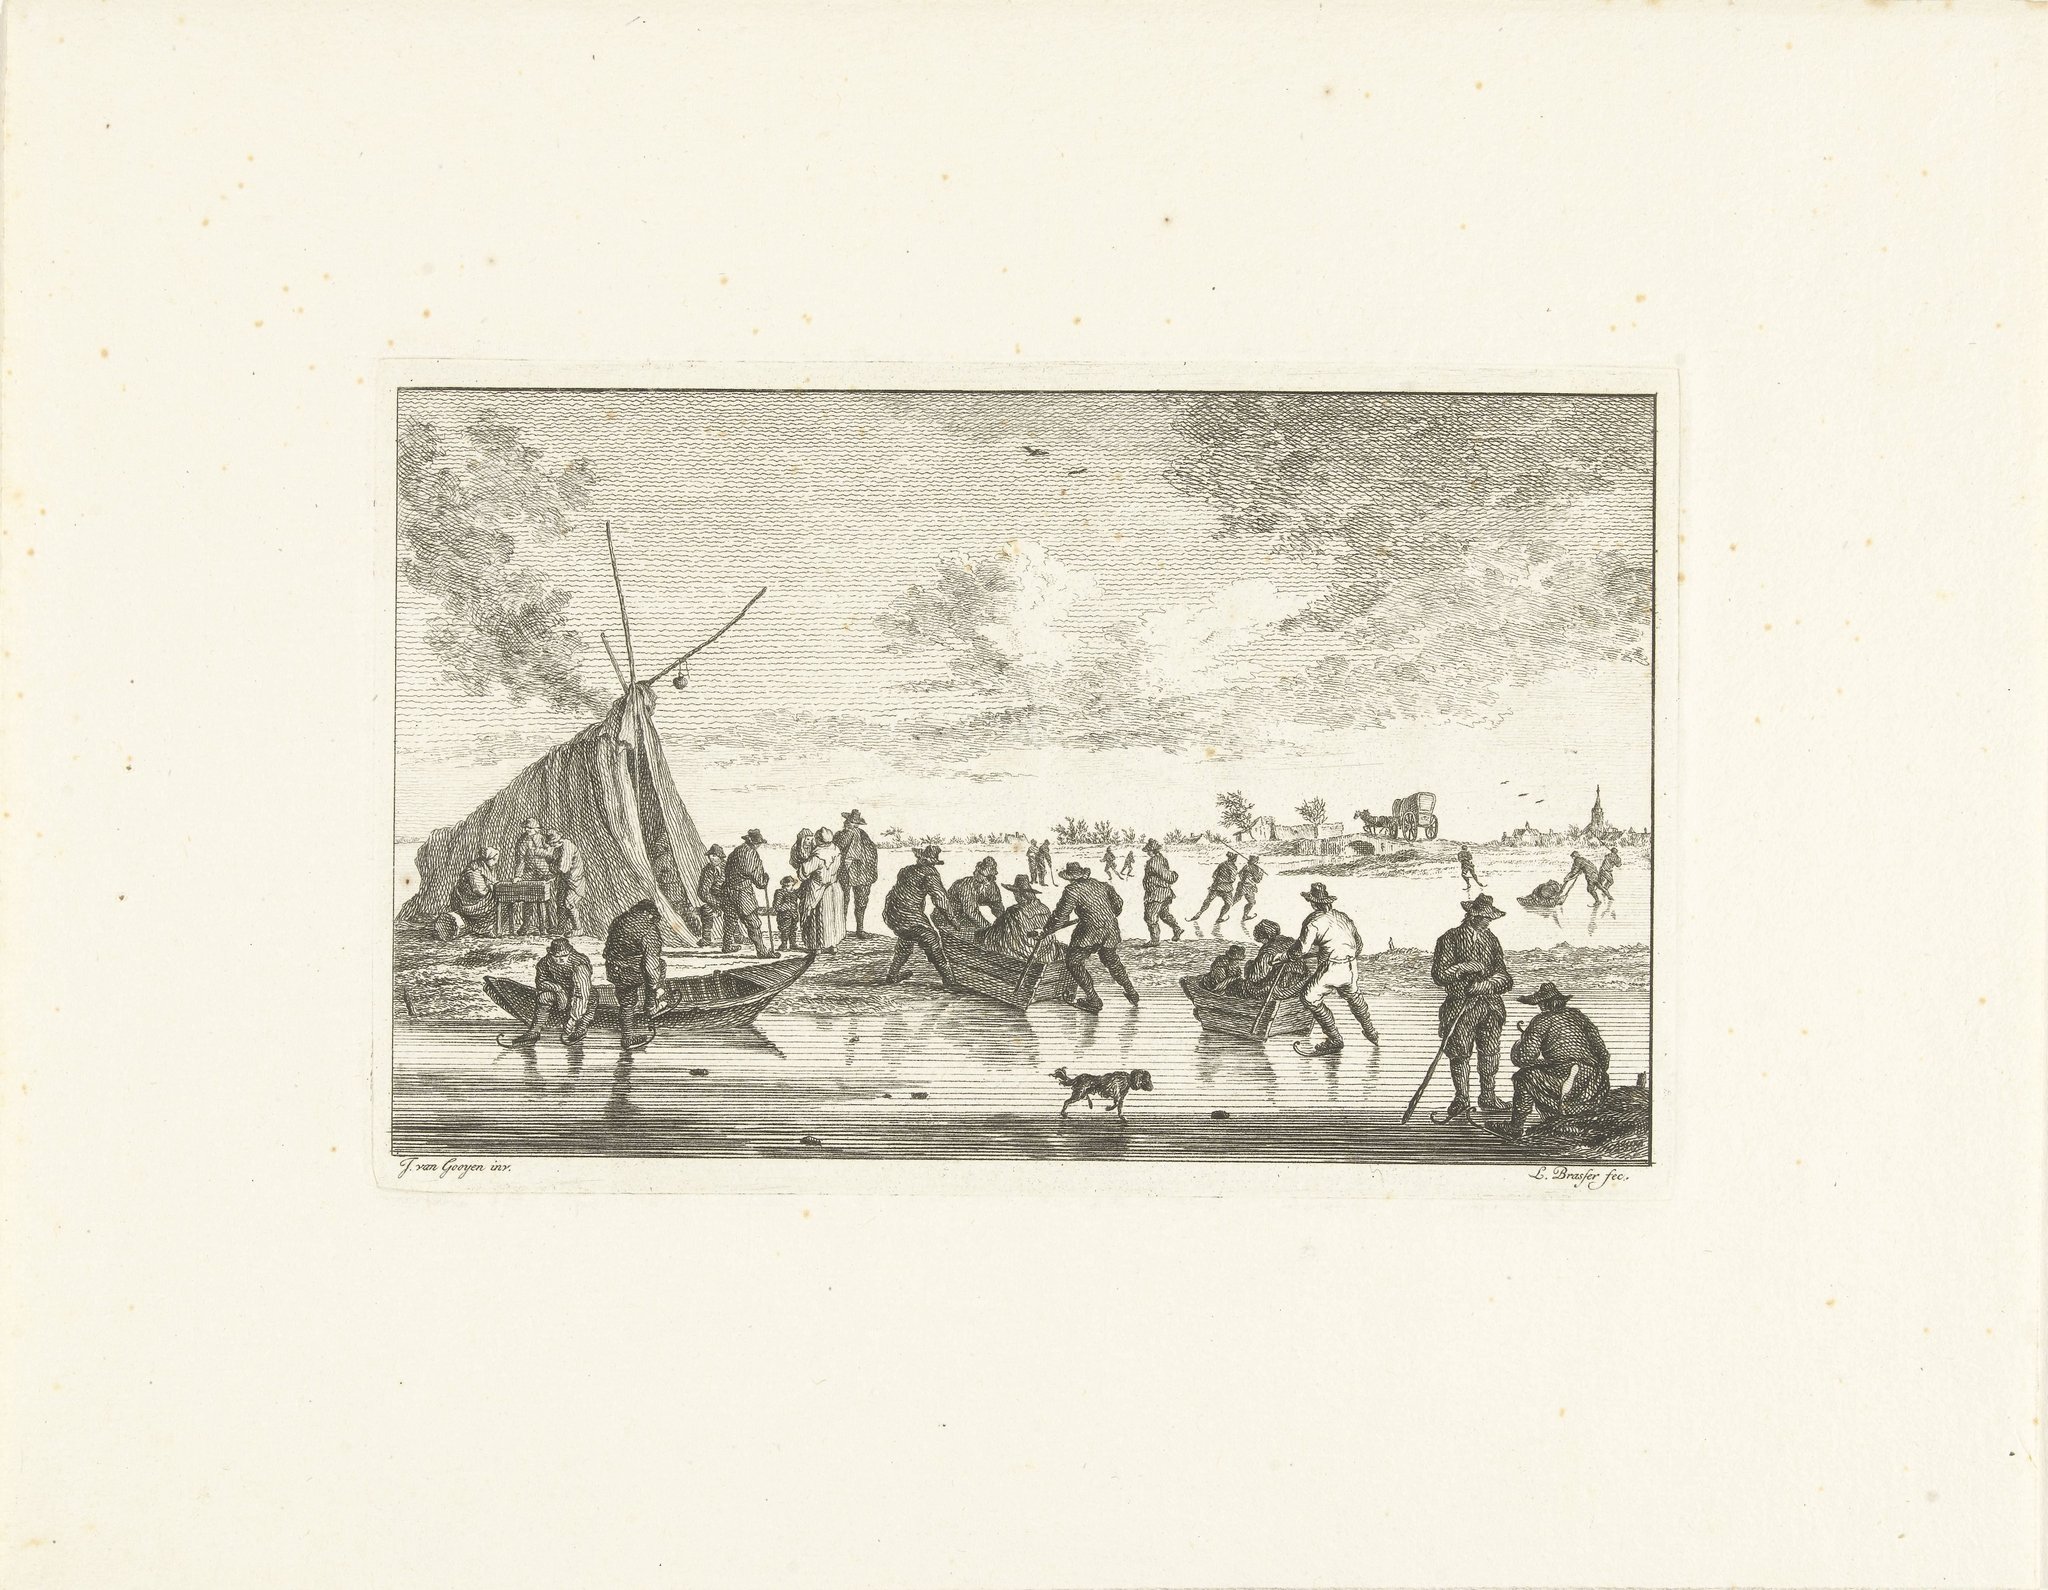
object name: print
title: Schaatsers en sleeën op het ijs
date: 1727-1793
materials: paper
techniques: etching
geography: netherlands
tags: skates (winter sports)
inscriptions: collector's mark: Lugt 240